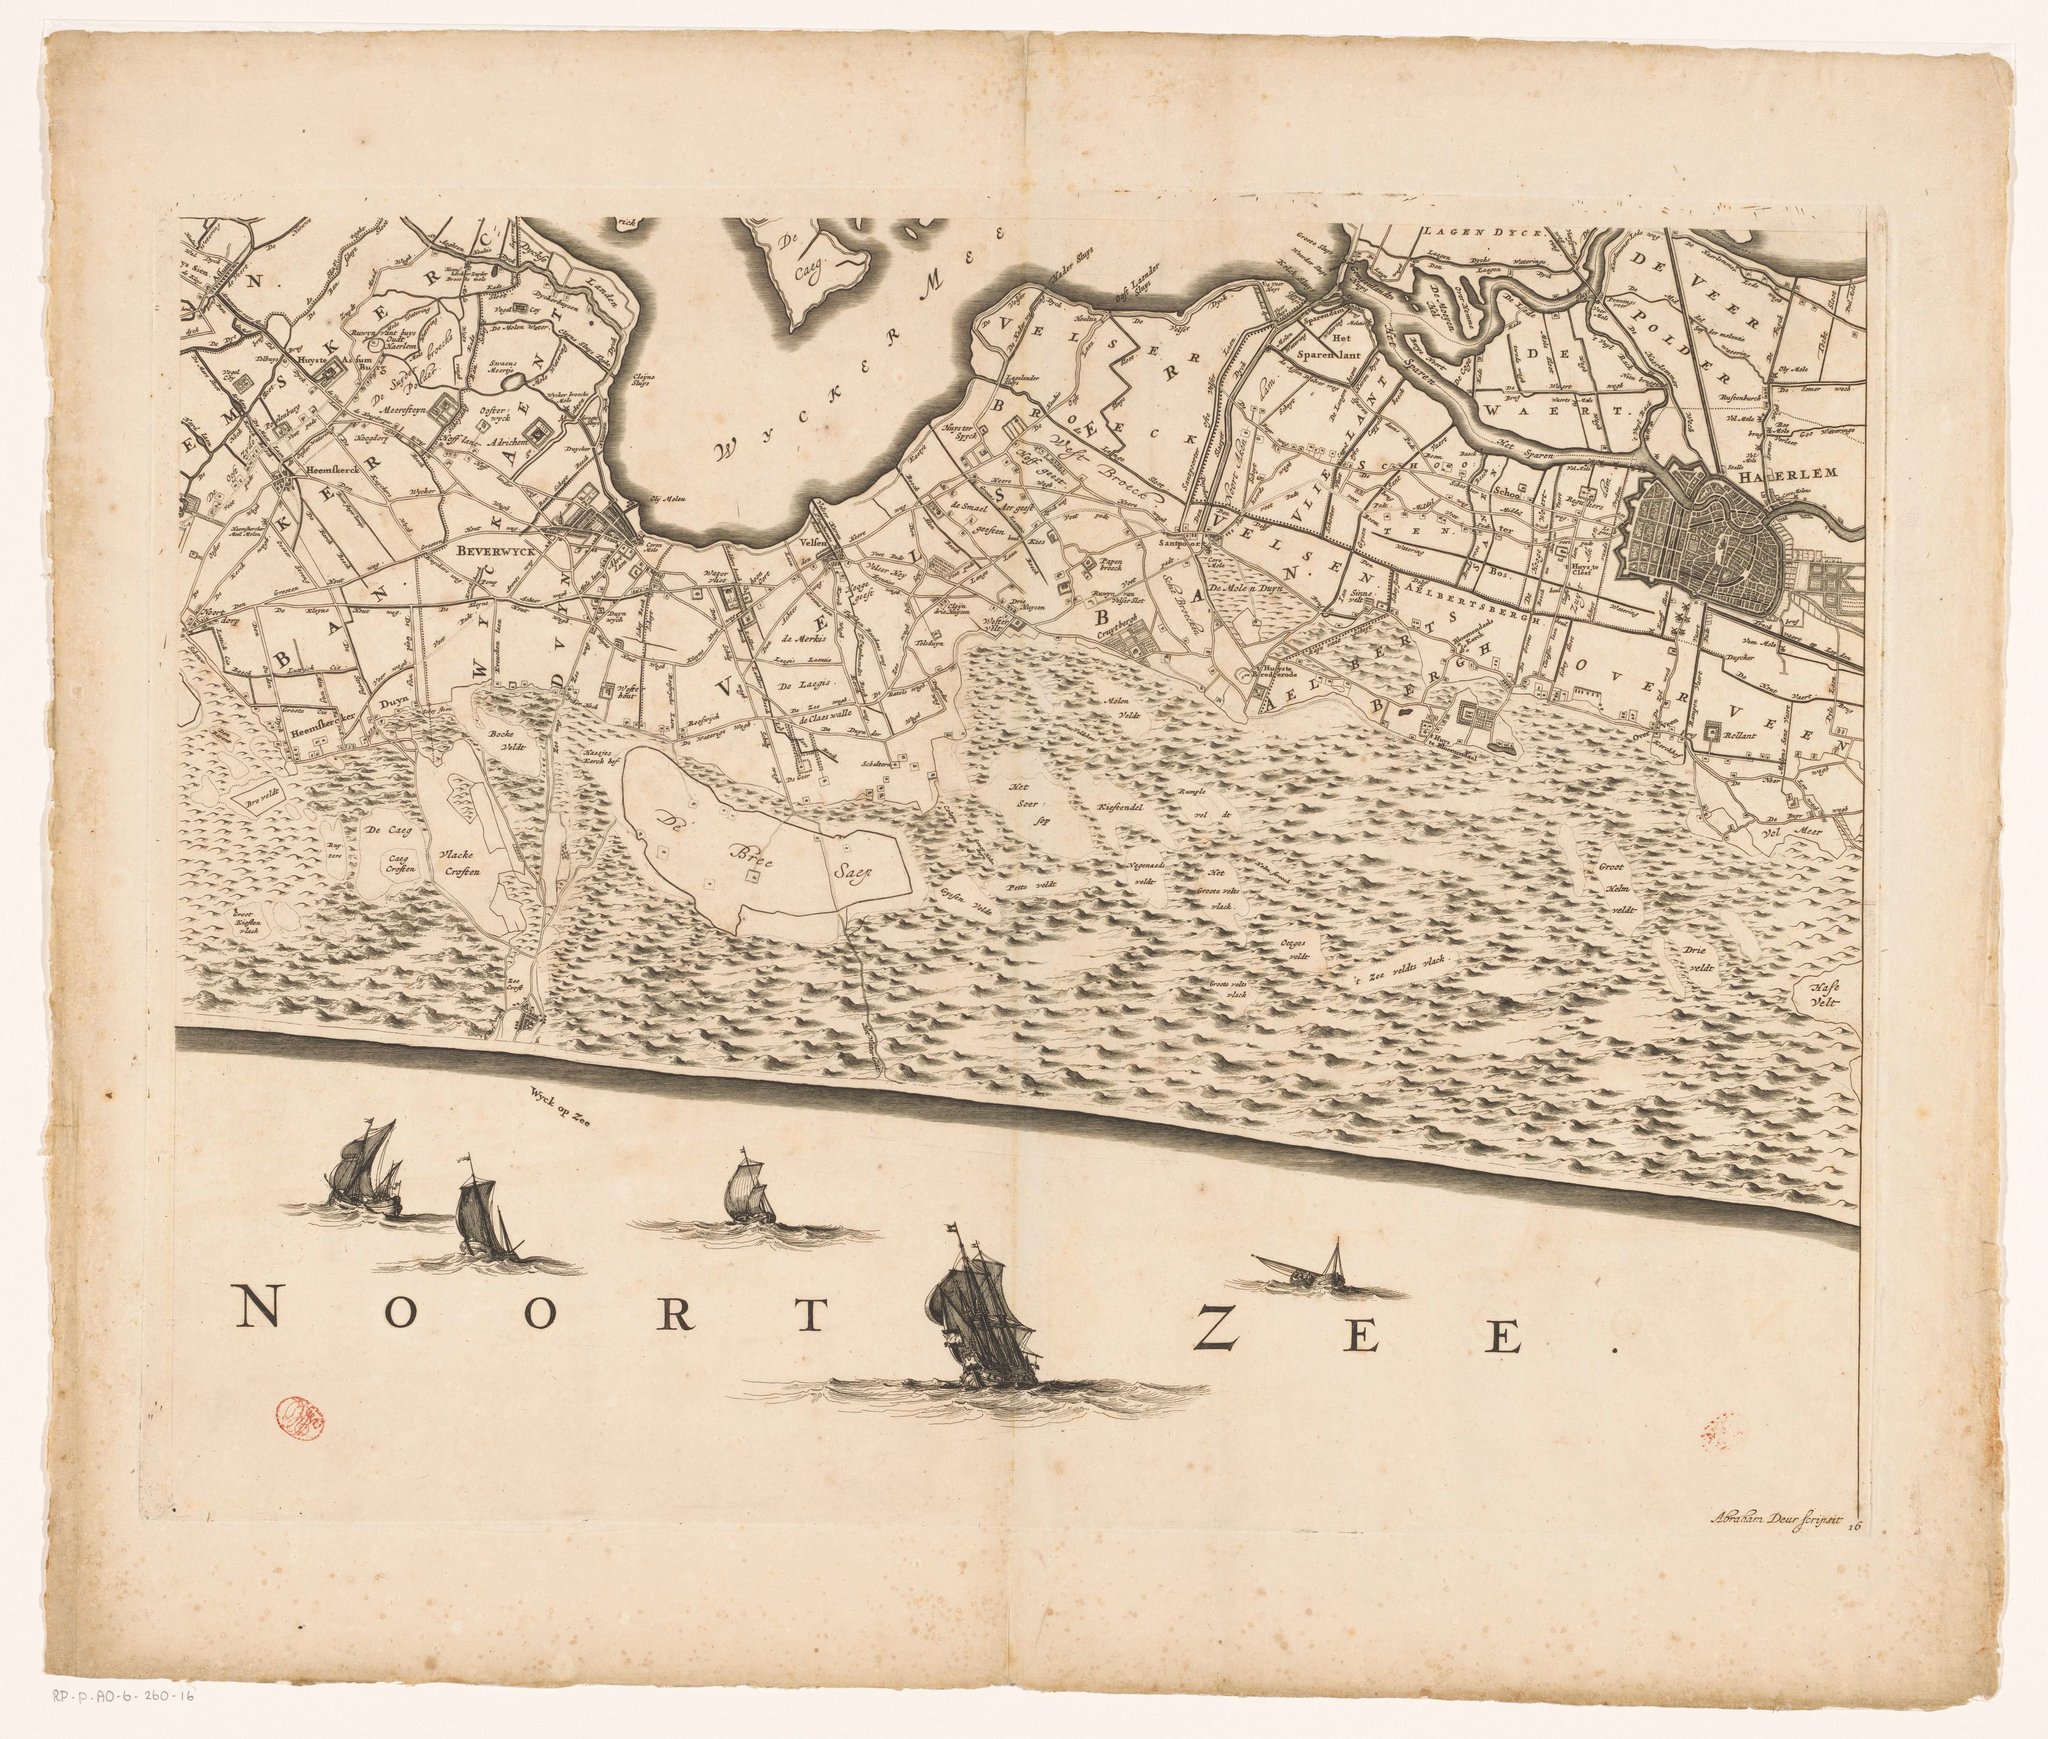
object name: map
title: 't Hoogh-heemraetschap vande Uytwaterende Sluysen in Kennemerlandt ende West-Frieslandt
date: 1680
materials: paper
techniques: engraving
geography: amsterdam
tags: maps of separate countries or regions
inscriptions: collector's mark: Lugt 195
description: Zestiende deel van een kaart van Kennemerland en West-Friesland. Rechtsonder genummerd: 16.